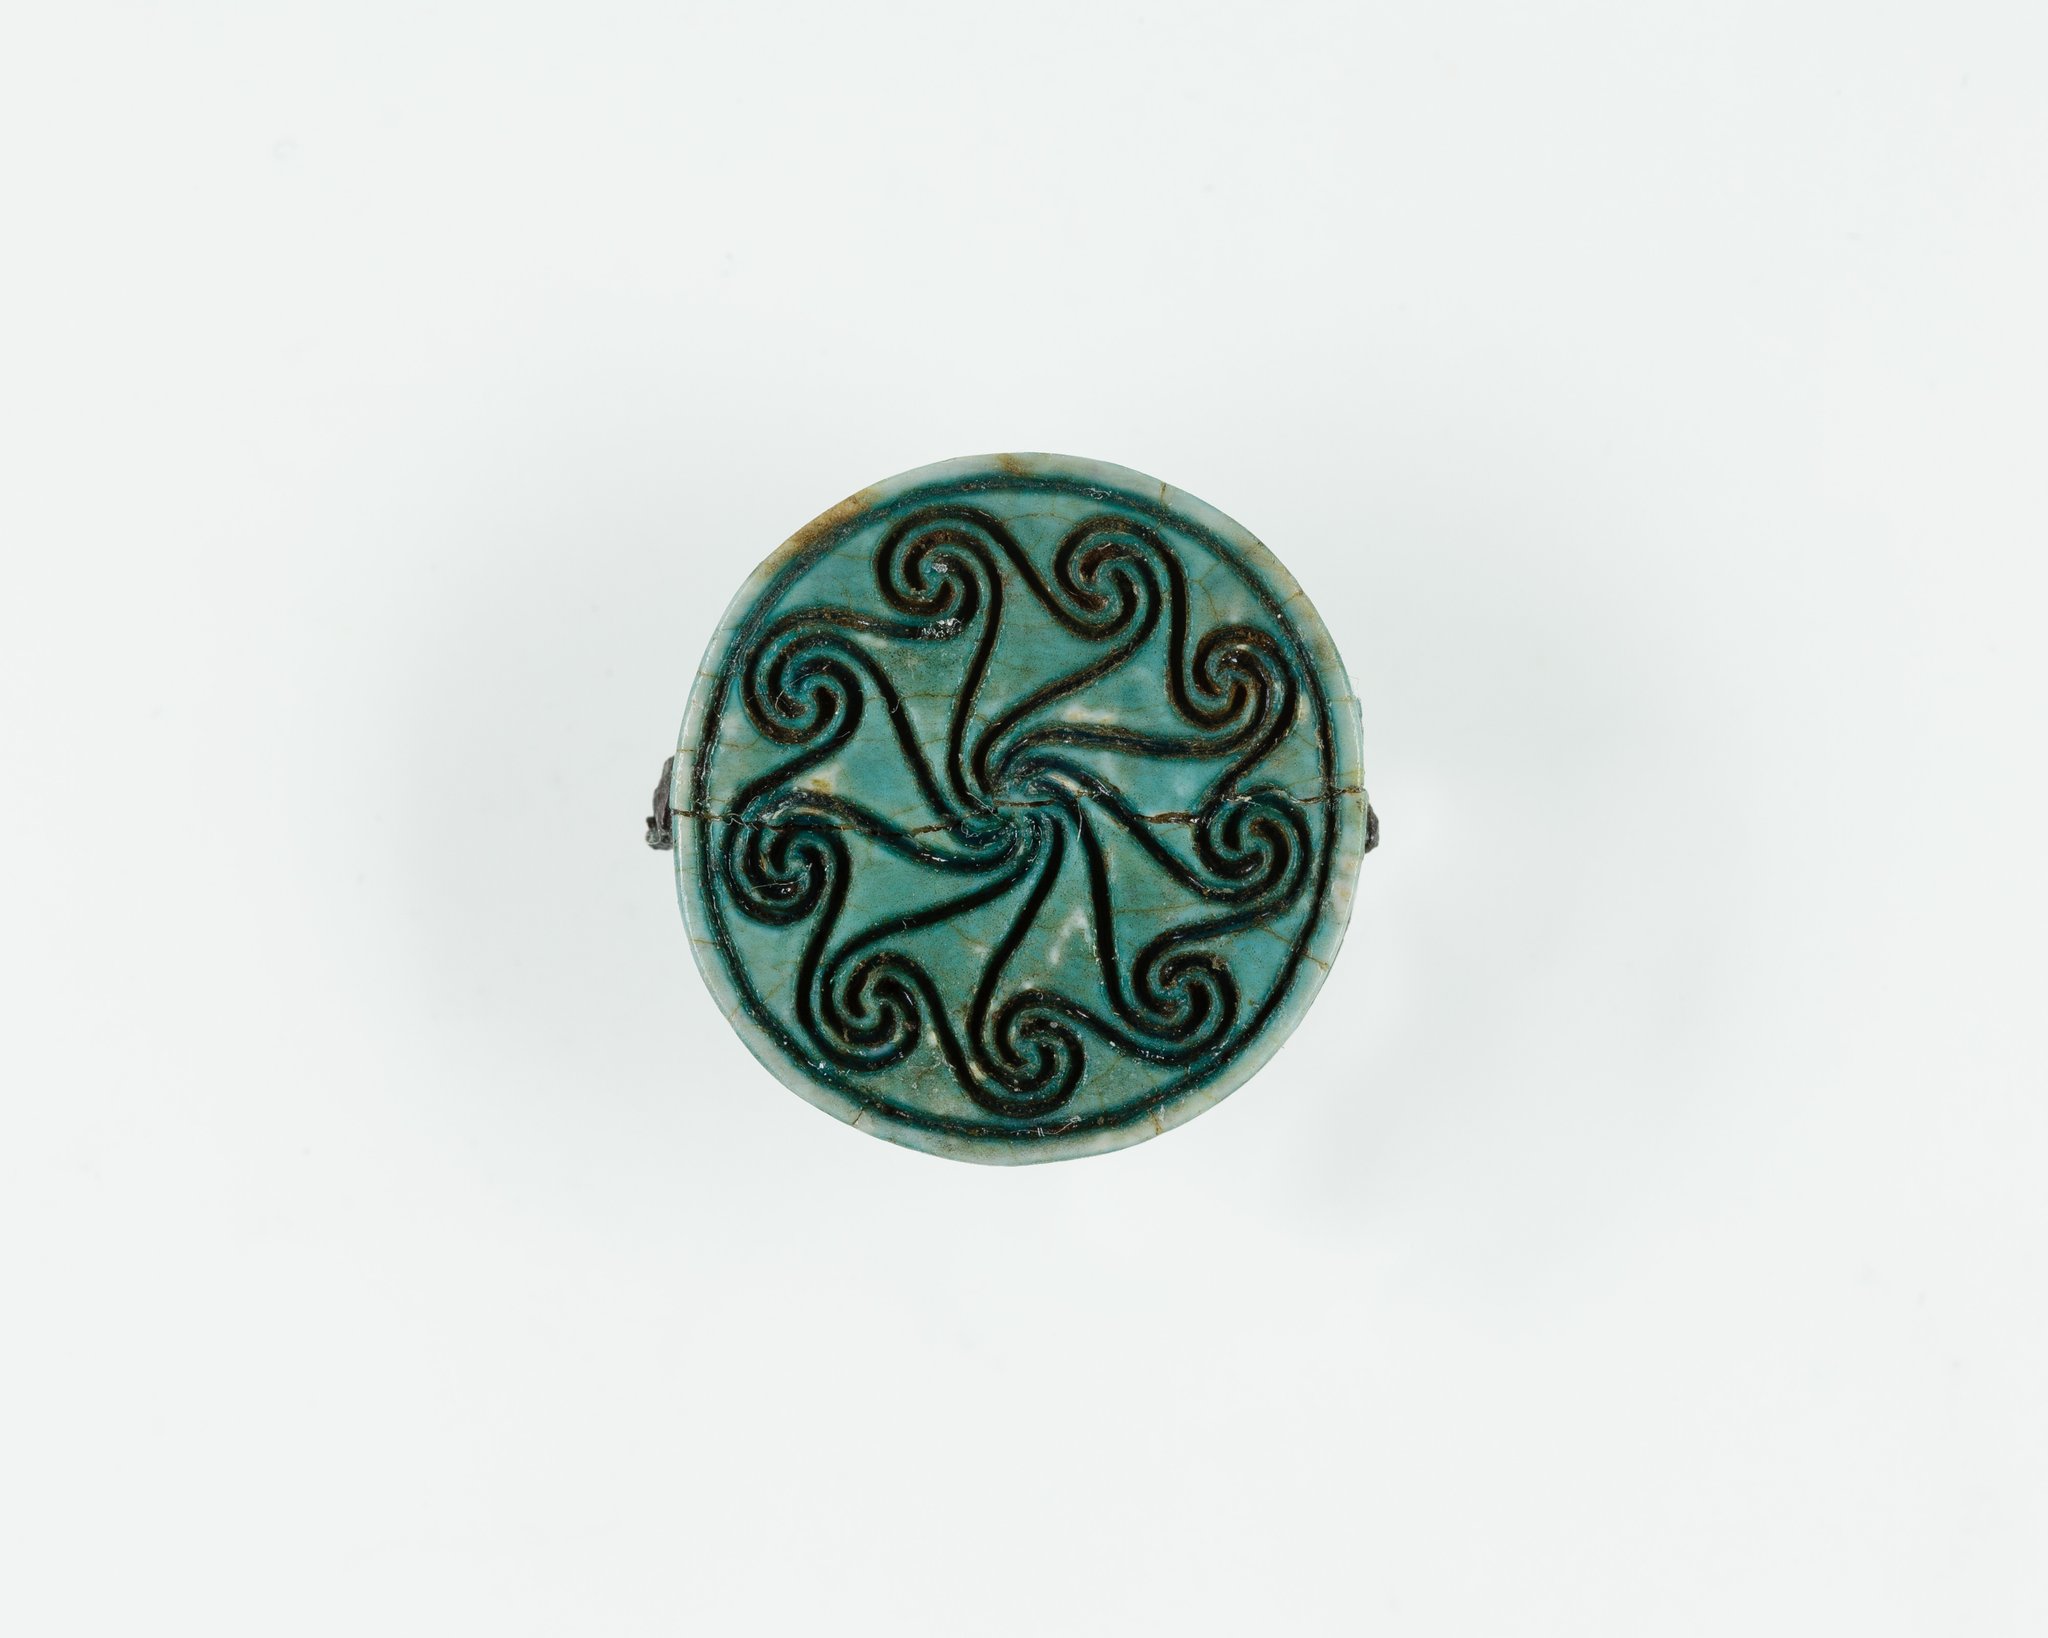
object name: button seal, openwork, falcon, cartouche senwosret iii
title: Button seal with the cartouches of Senwosret III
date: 1878-1650 BCE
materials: metal, stone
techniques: glazing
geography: egypt